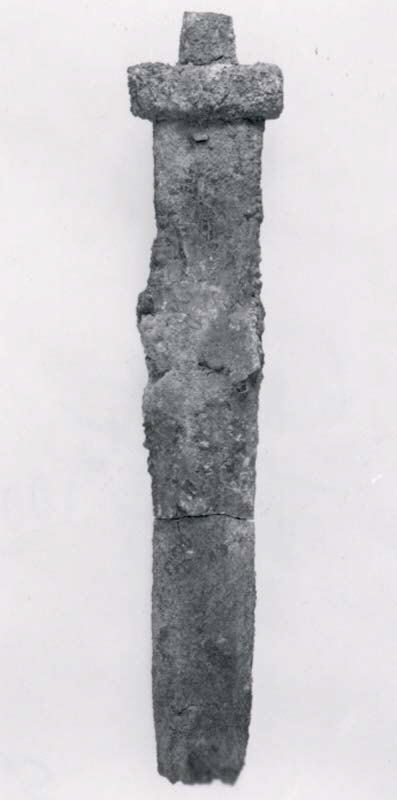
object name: dagger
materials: iron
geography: mesopotamia